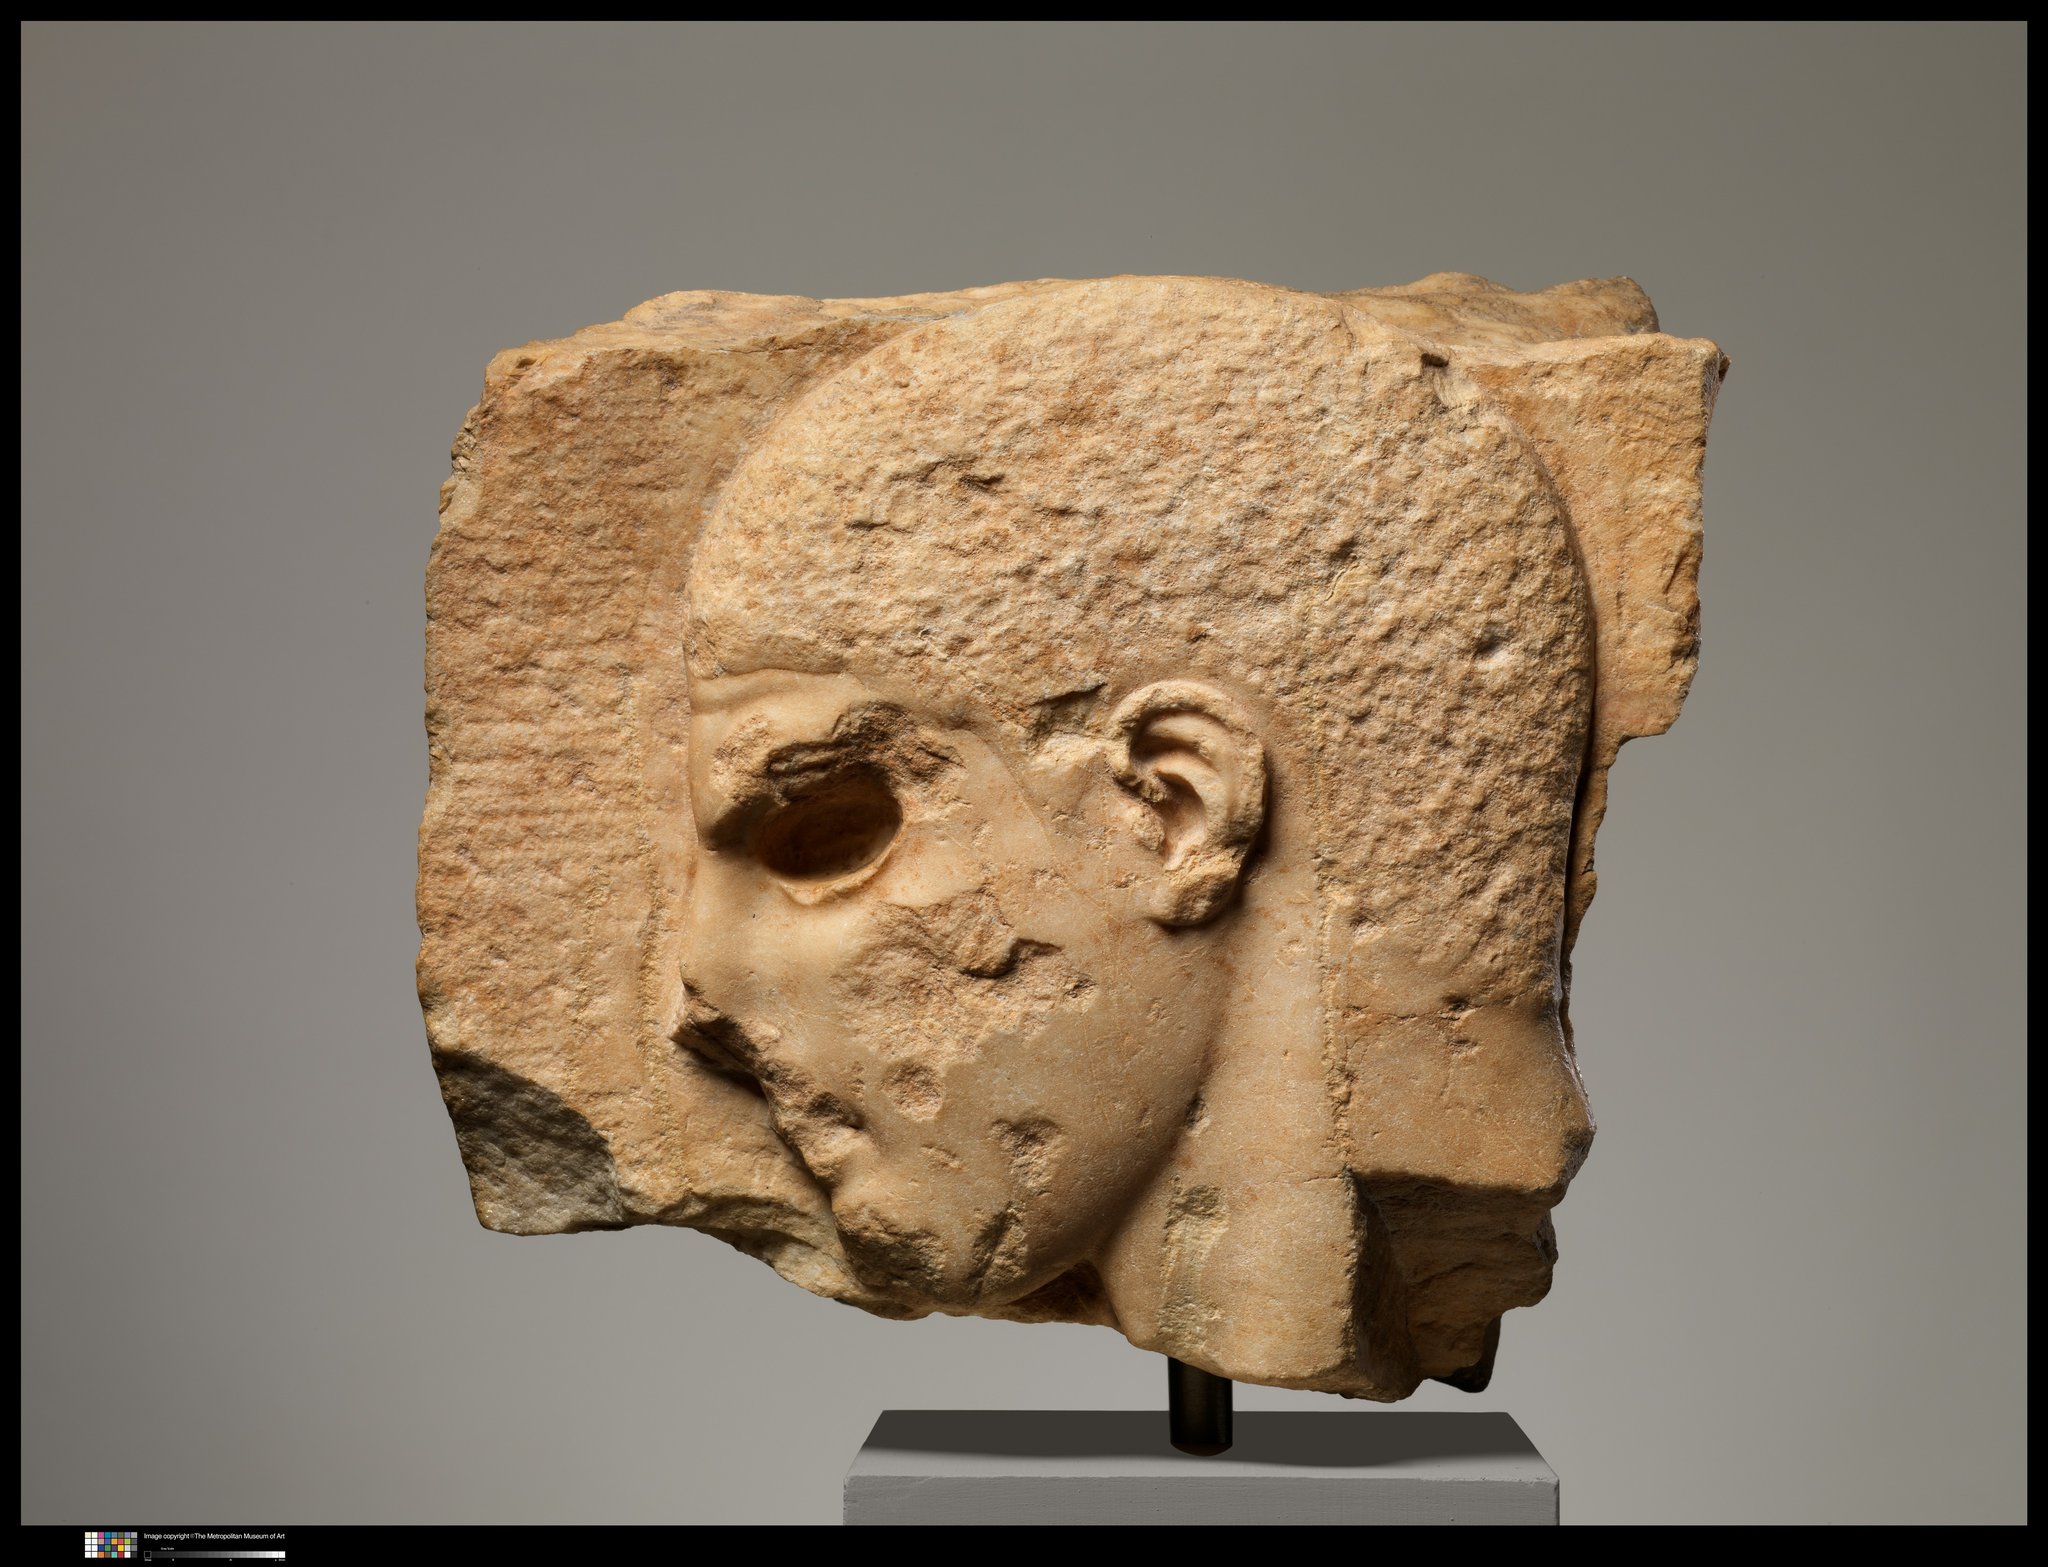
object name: grave relief fragment, head of a youth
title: Fragment of a marble grave stele with the head of a youth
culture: greek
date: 500-476 BCE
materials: marble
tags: heads